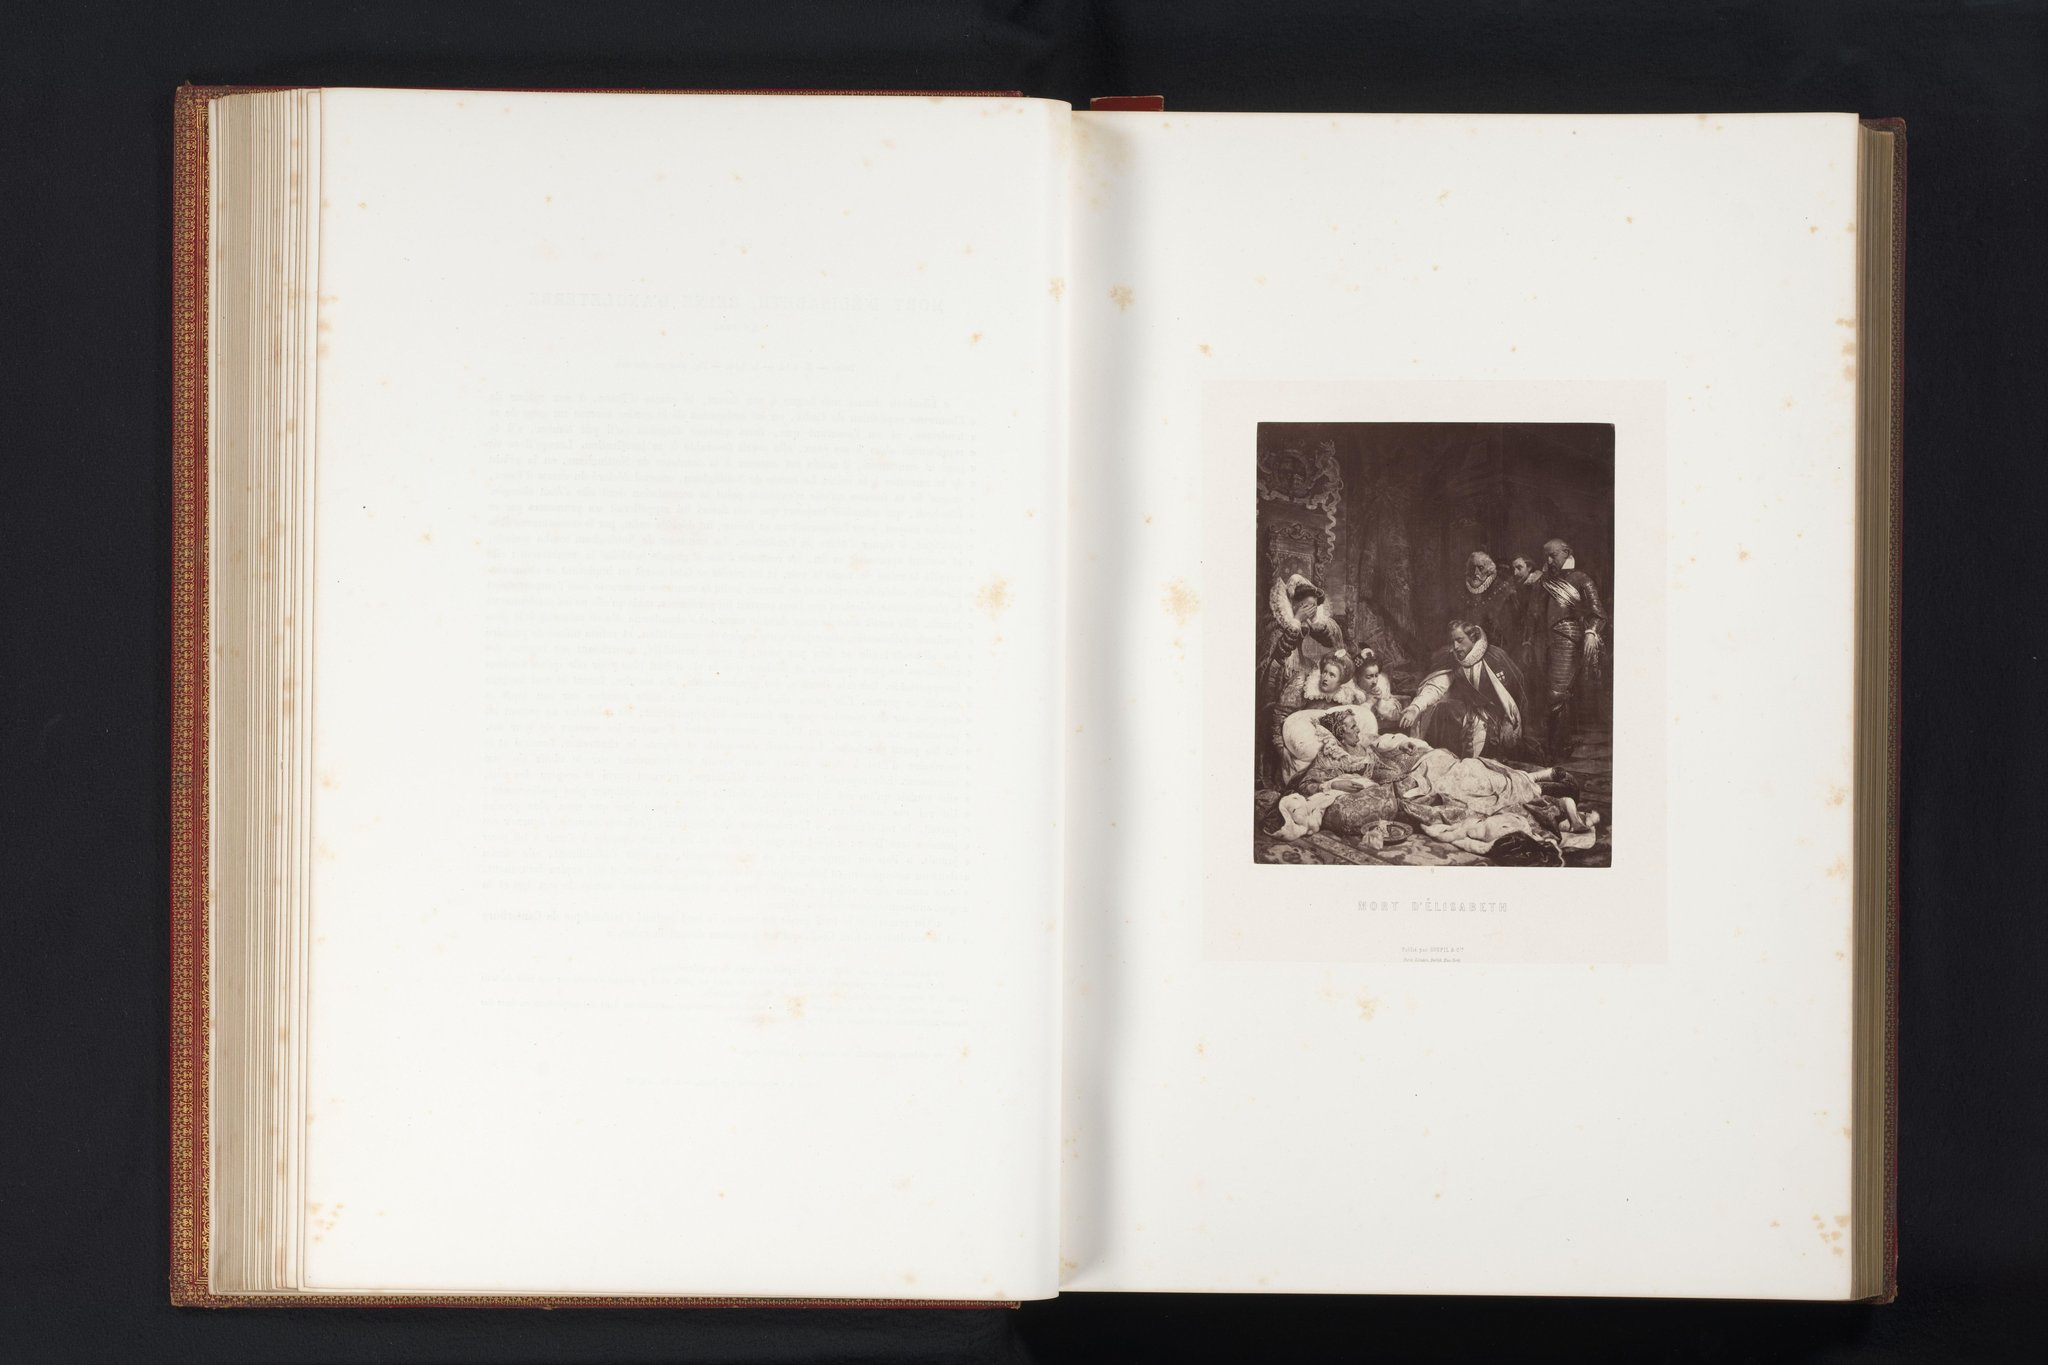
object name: photograph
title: Mort d'Élisabeth, Reine d'Angleterre en 1603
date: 1853-1858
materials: paper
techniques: albumen print, engraving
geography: paris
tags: london, deathbed, queen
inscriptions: check stamp: ‘Goupil & Cie’